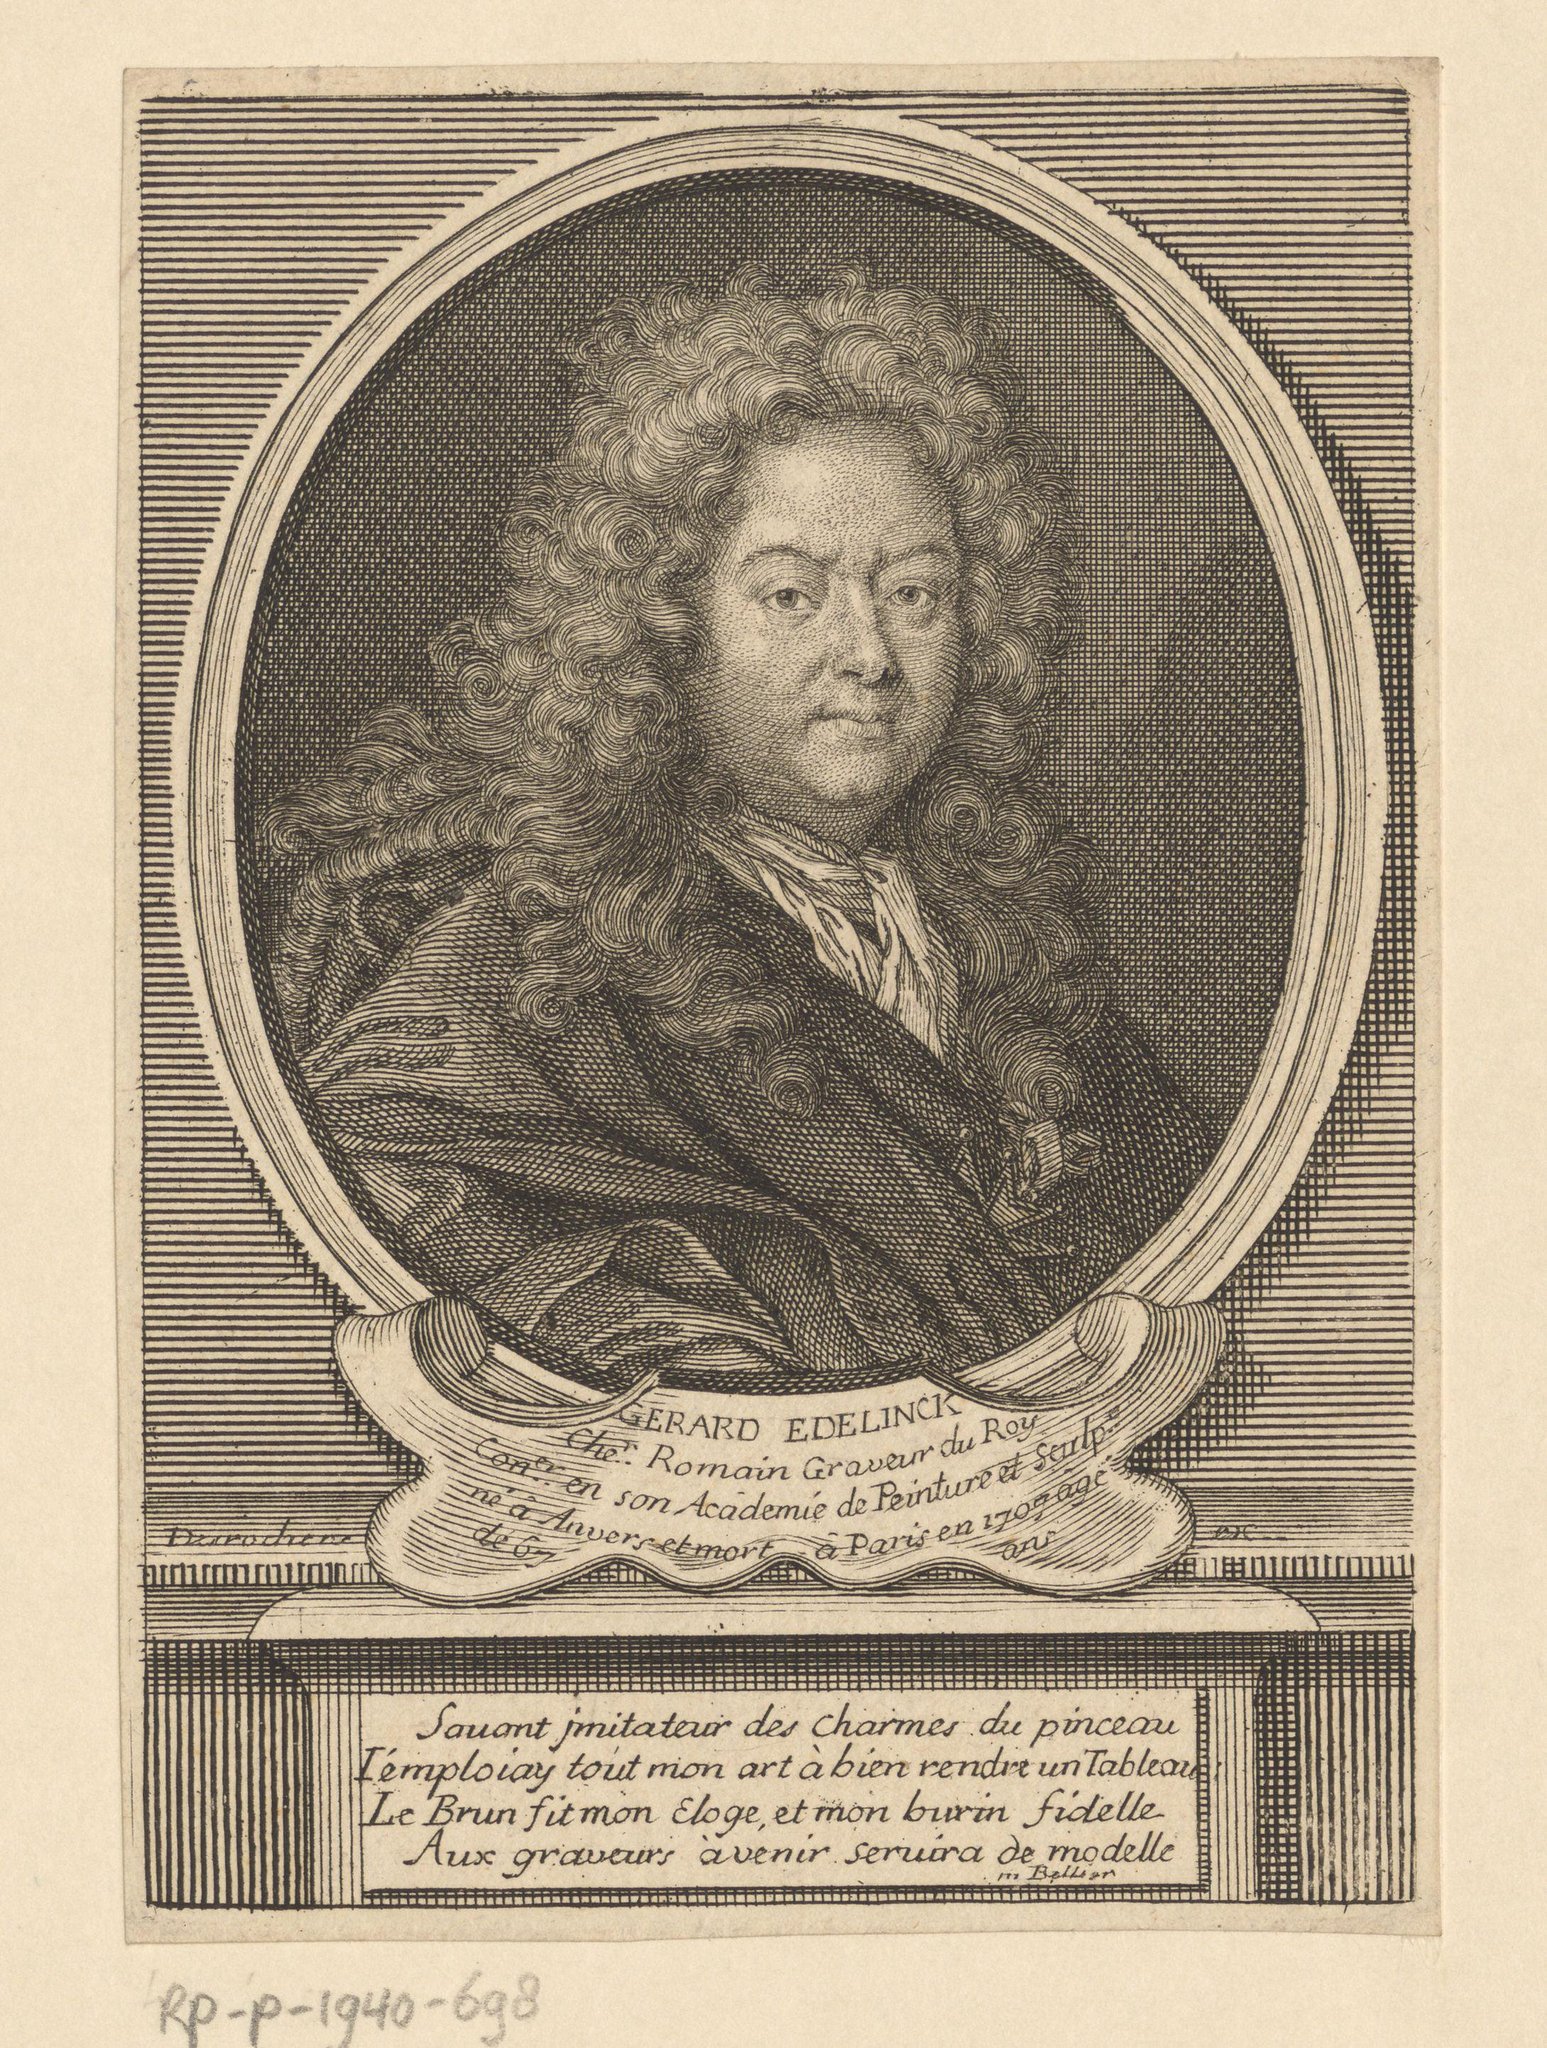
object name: print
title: Verzameling portretten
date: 1726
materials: paper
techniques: engraving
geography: paris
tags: gerard edelinck, historical persons, portrait, self-portrait of graphic artist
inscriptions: collector's mark: Lugt 2760, collector's mark: Lugt 2228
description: Behoort waarschijnlijk tot een serie portretten, grotendeels door Etienne Desrochers, getiteld: 'Recueil de portraits de personnes qui se sont distinguées tant dans les Armes que dans Belles-Lettres et les Arts, comme aussi la famille royale de France et autres cours étrangères'. De serie werd aangekondigd in de Mercure in mei 1726, maar Desrochers was enkele jaren daarvoor al begonnen met het uitgeven van de serie. Na de dood van Desrochers werd de serie voortgezet door Gilles Edme Petit.